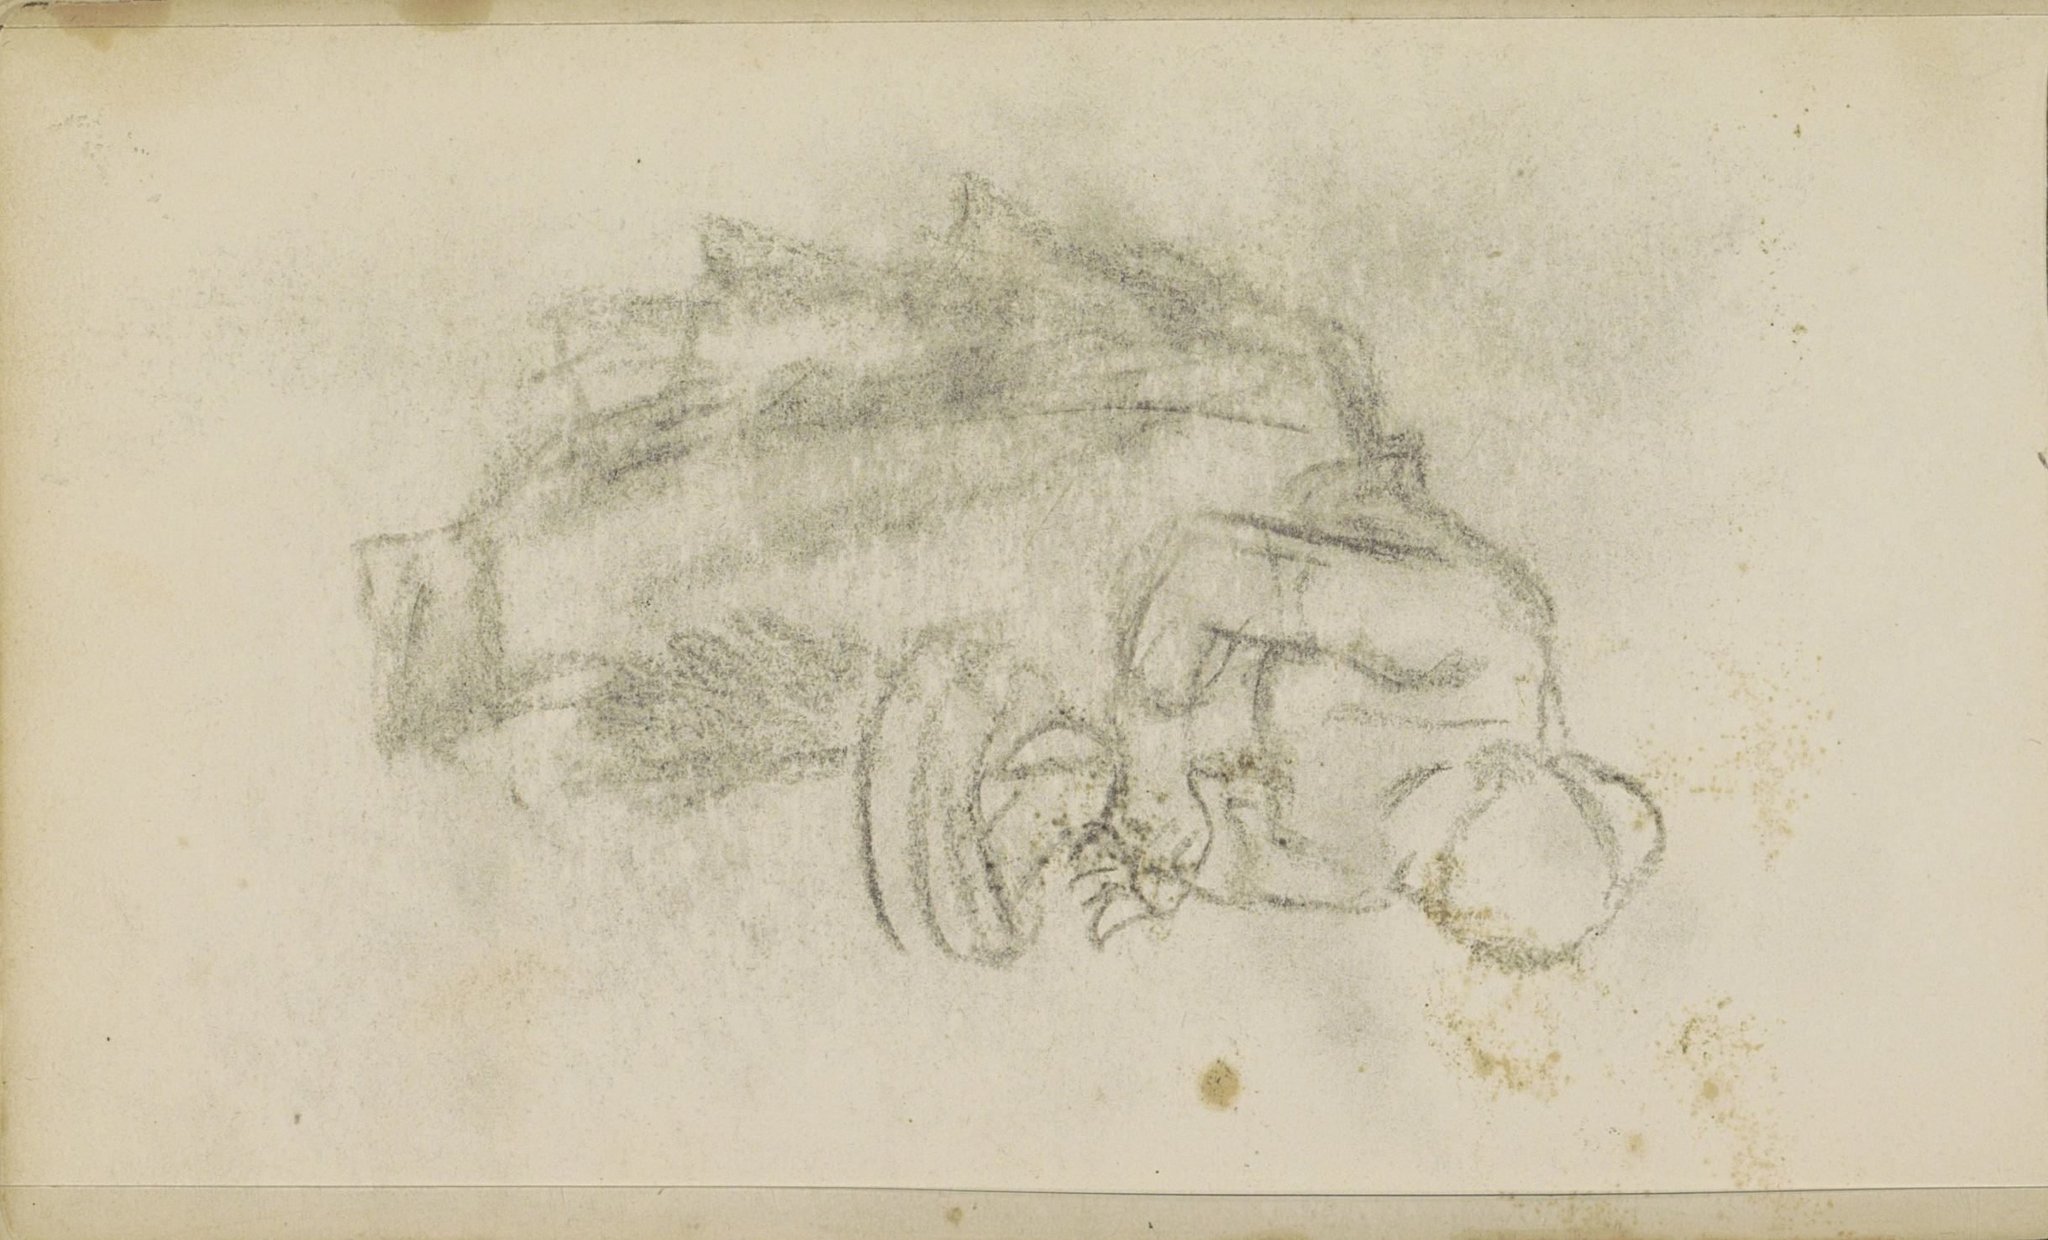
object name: sketchbook leaf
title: Vrouw met een mand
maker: jozef israëls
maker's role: draughtsman, painter, print maker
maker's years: 1824-1911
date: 1834-1911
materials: chalk, paper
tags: bending figure (+ female (human being) (not to be used where -aa- is prescribed)), container made of plant material other than wood: basket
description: De vrouw buigt voorover. Blad 12 verso uit een schetsboek met 42 bladen.